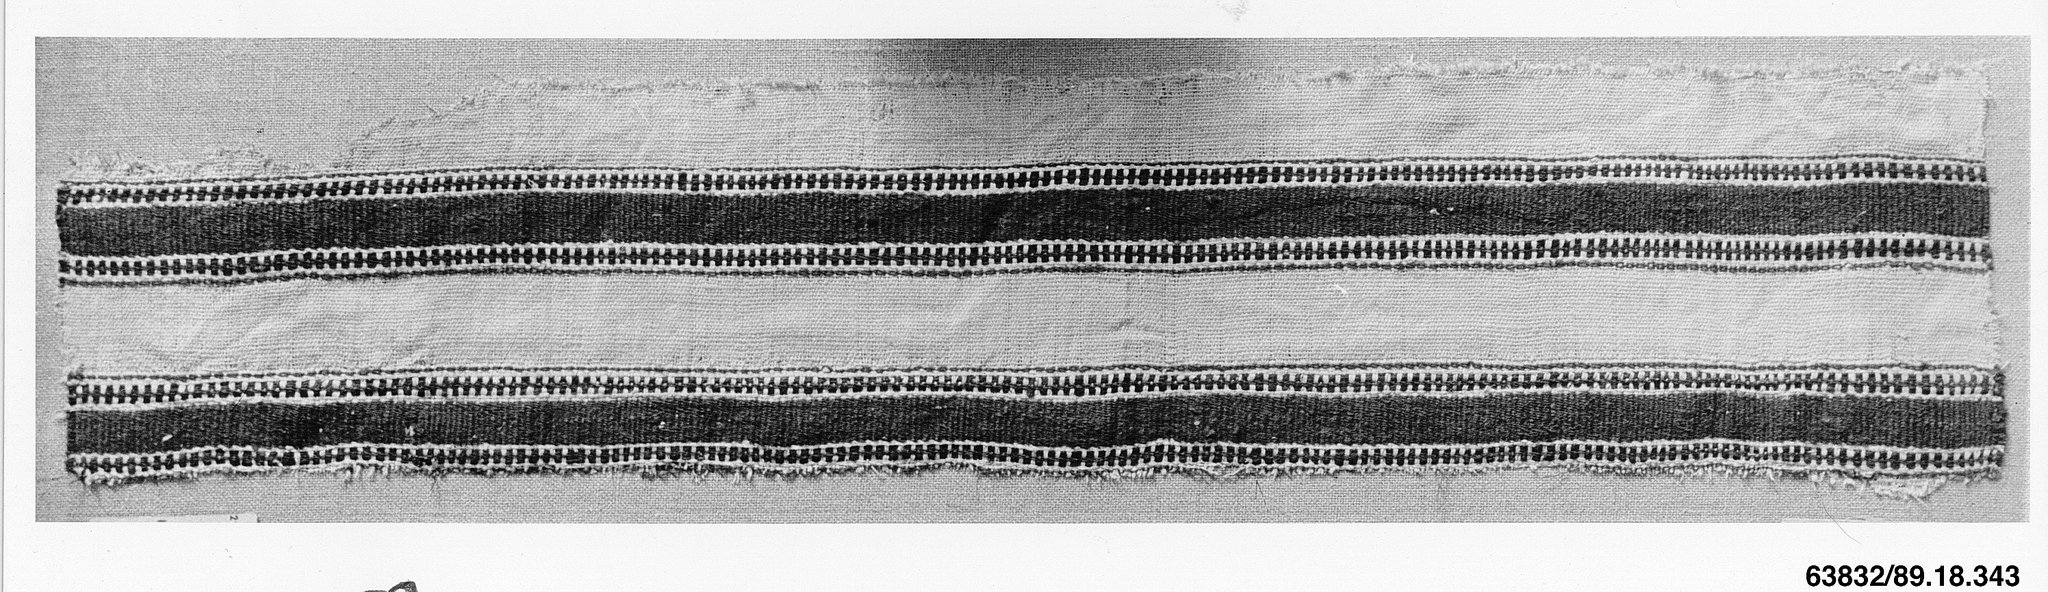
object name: textile fragment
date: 201-400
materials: linen, wool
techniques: weave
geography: egypt